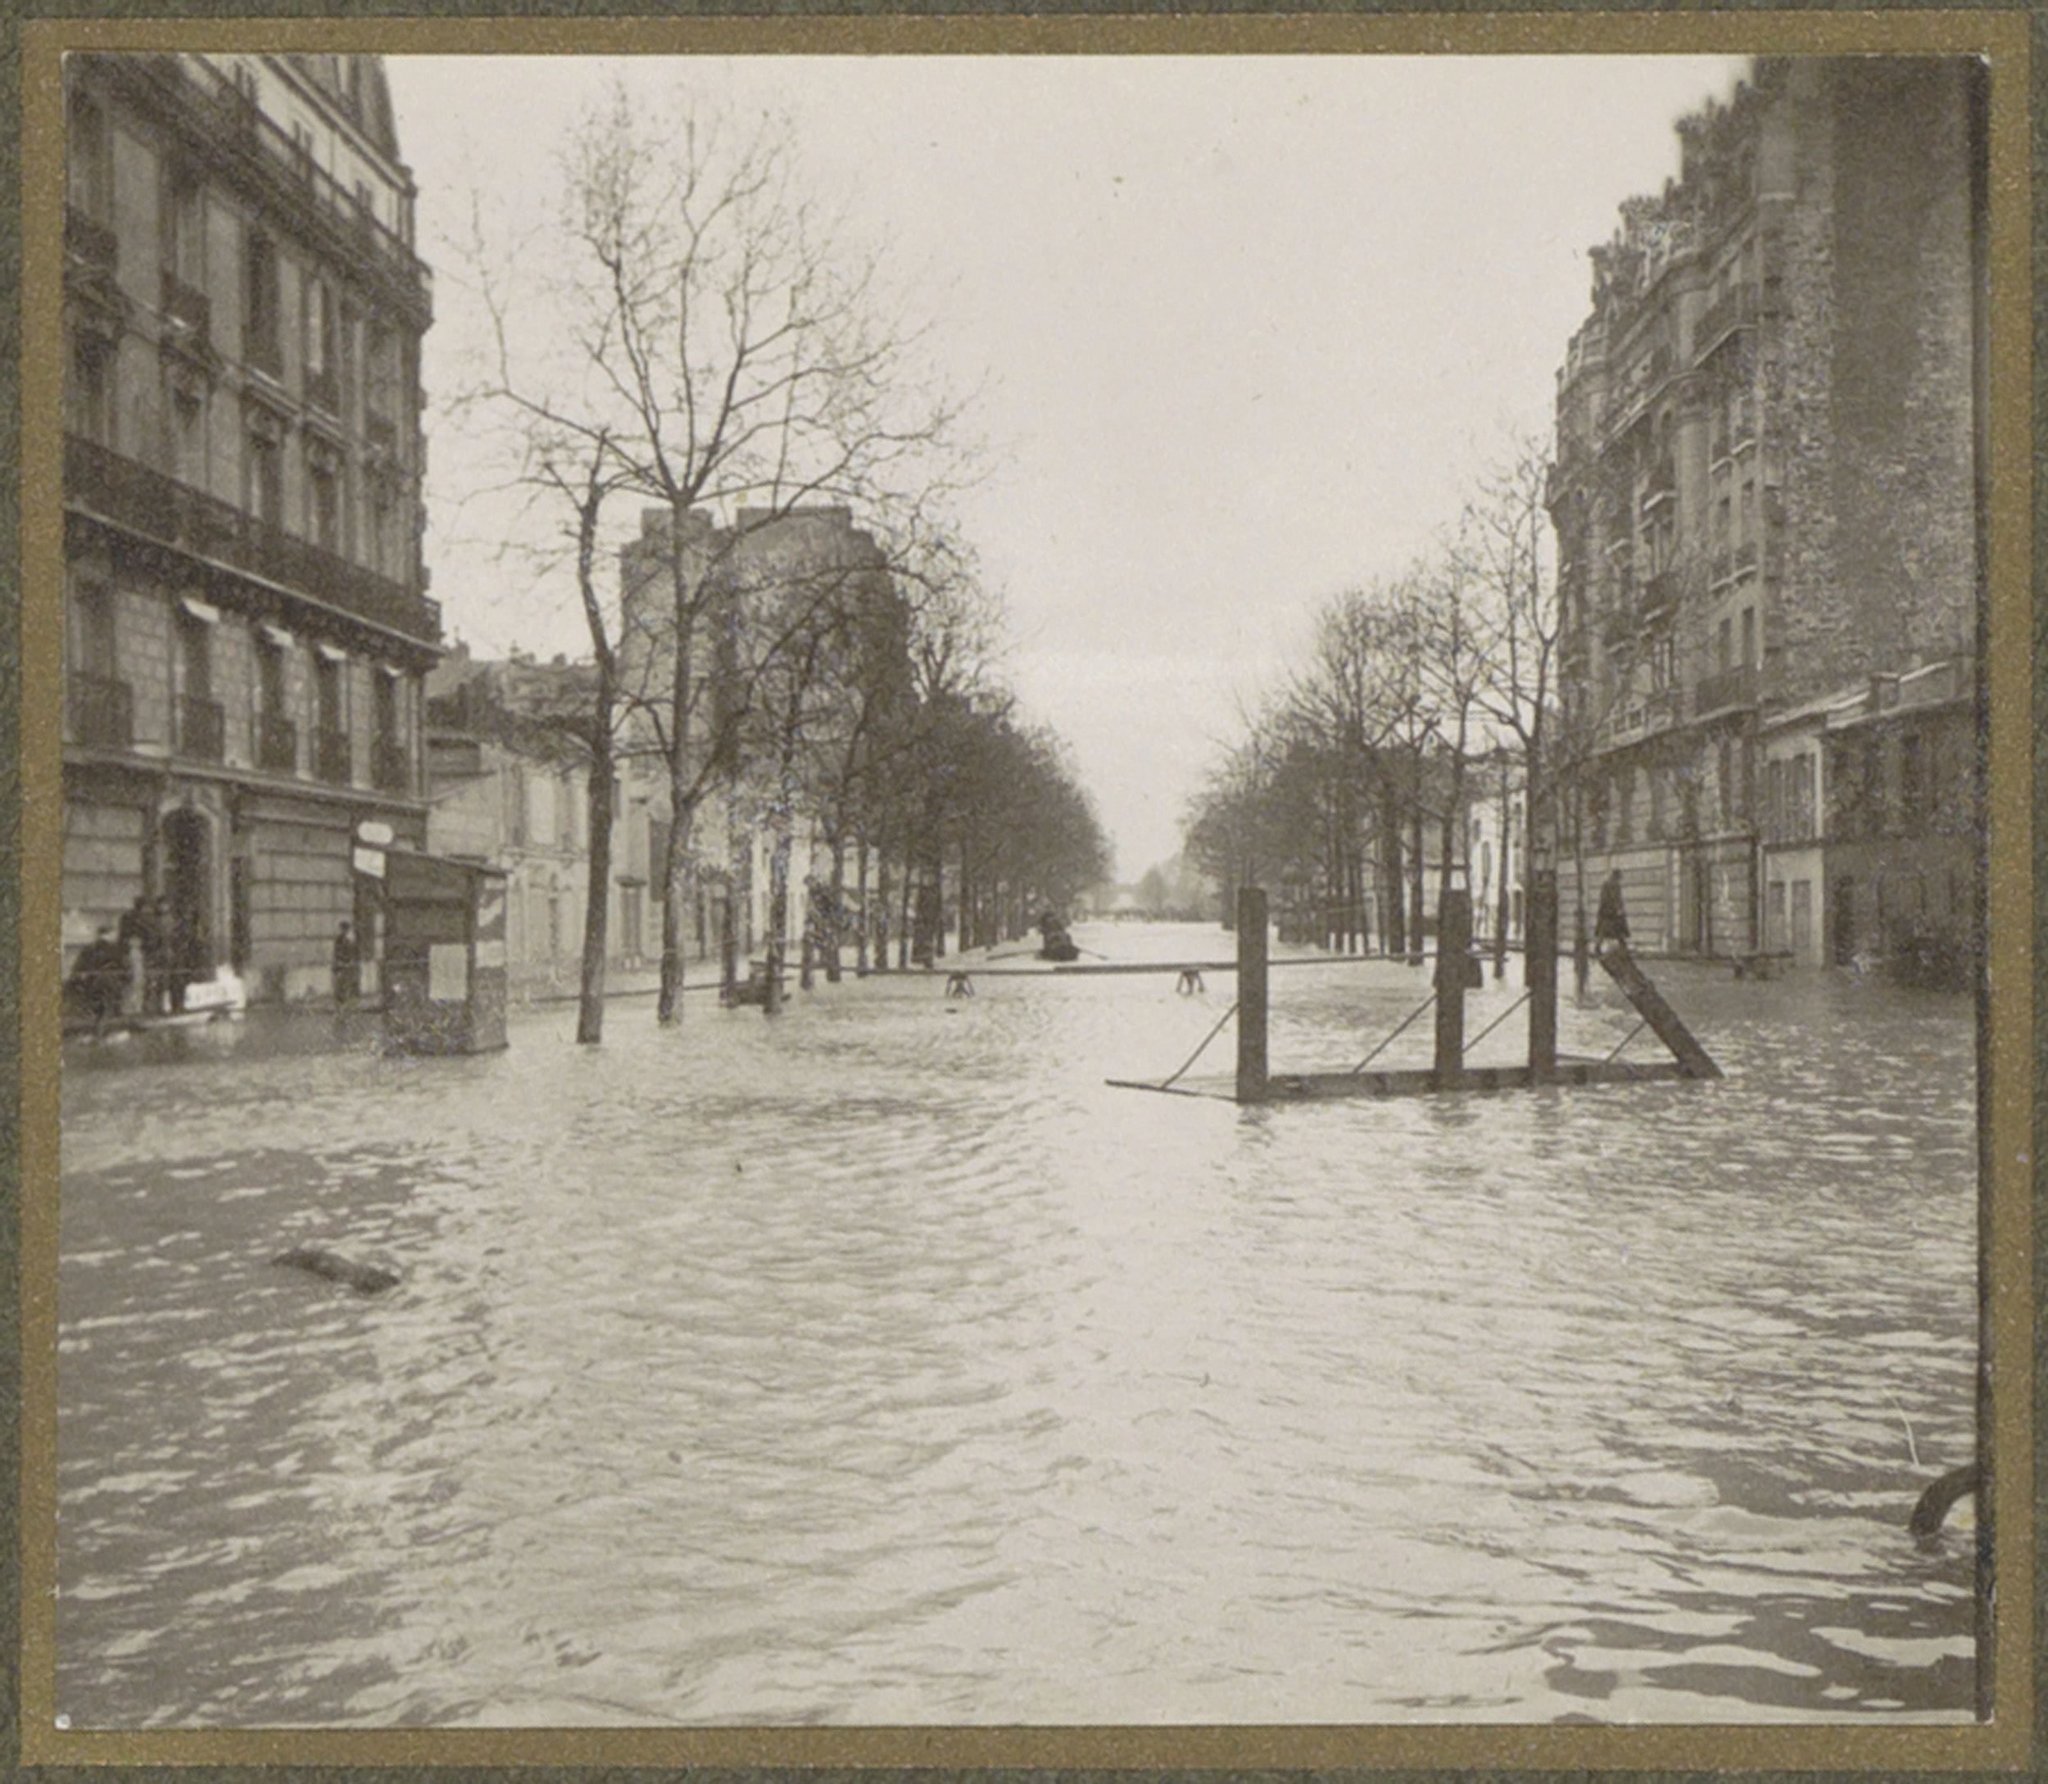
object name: photograph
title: Overstroomde straat met loopplanken in Parijs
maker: g. dangereux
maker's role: fotograaf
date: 1901-1910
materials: photographic support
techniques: matte daylight collodion silver print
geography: paris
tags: flood (+ landscape with figures, staffage), paris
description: Onderdeel van fotoalbum overstroming Parijs en voorsteden 1910.